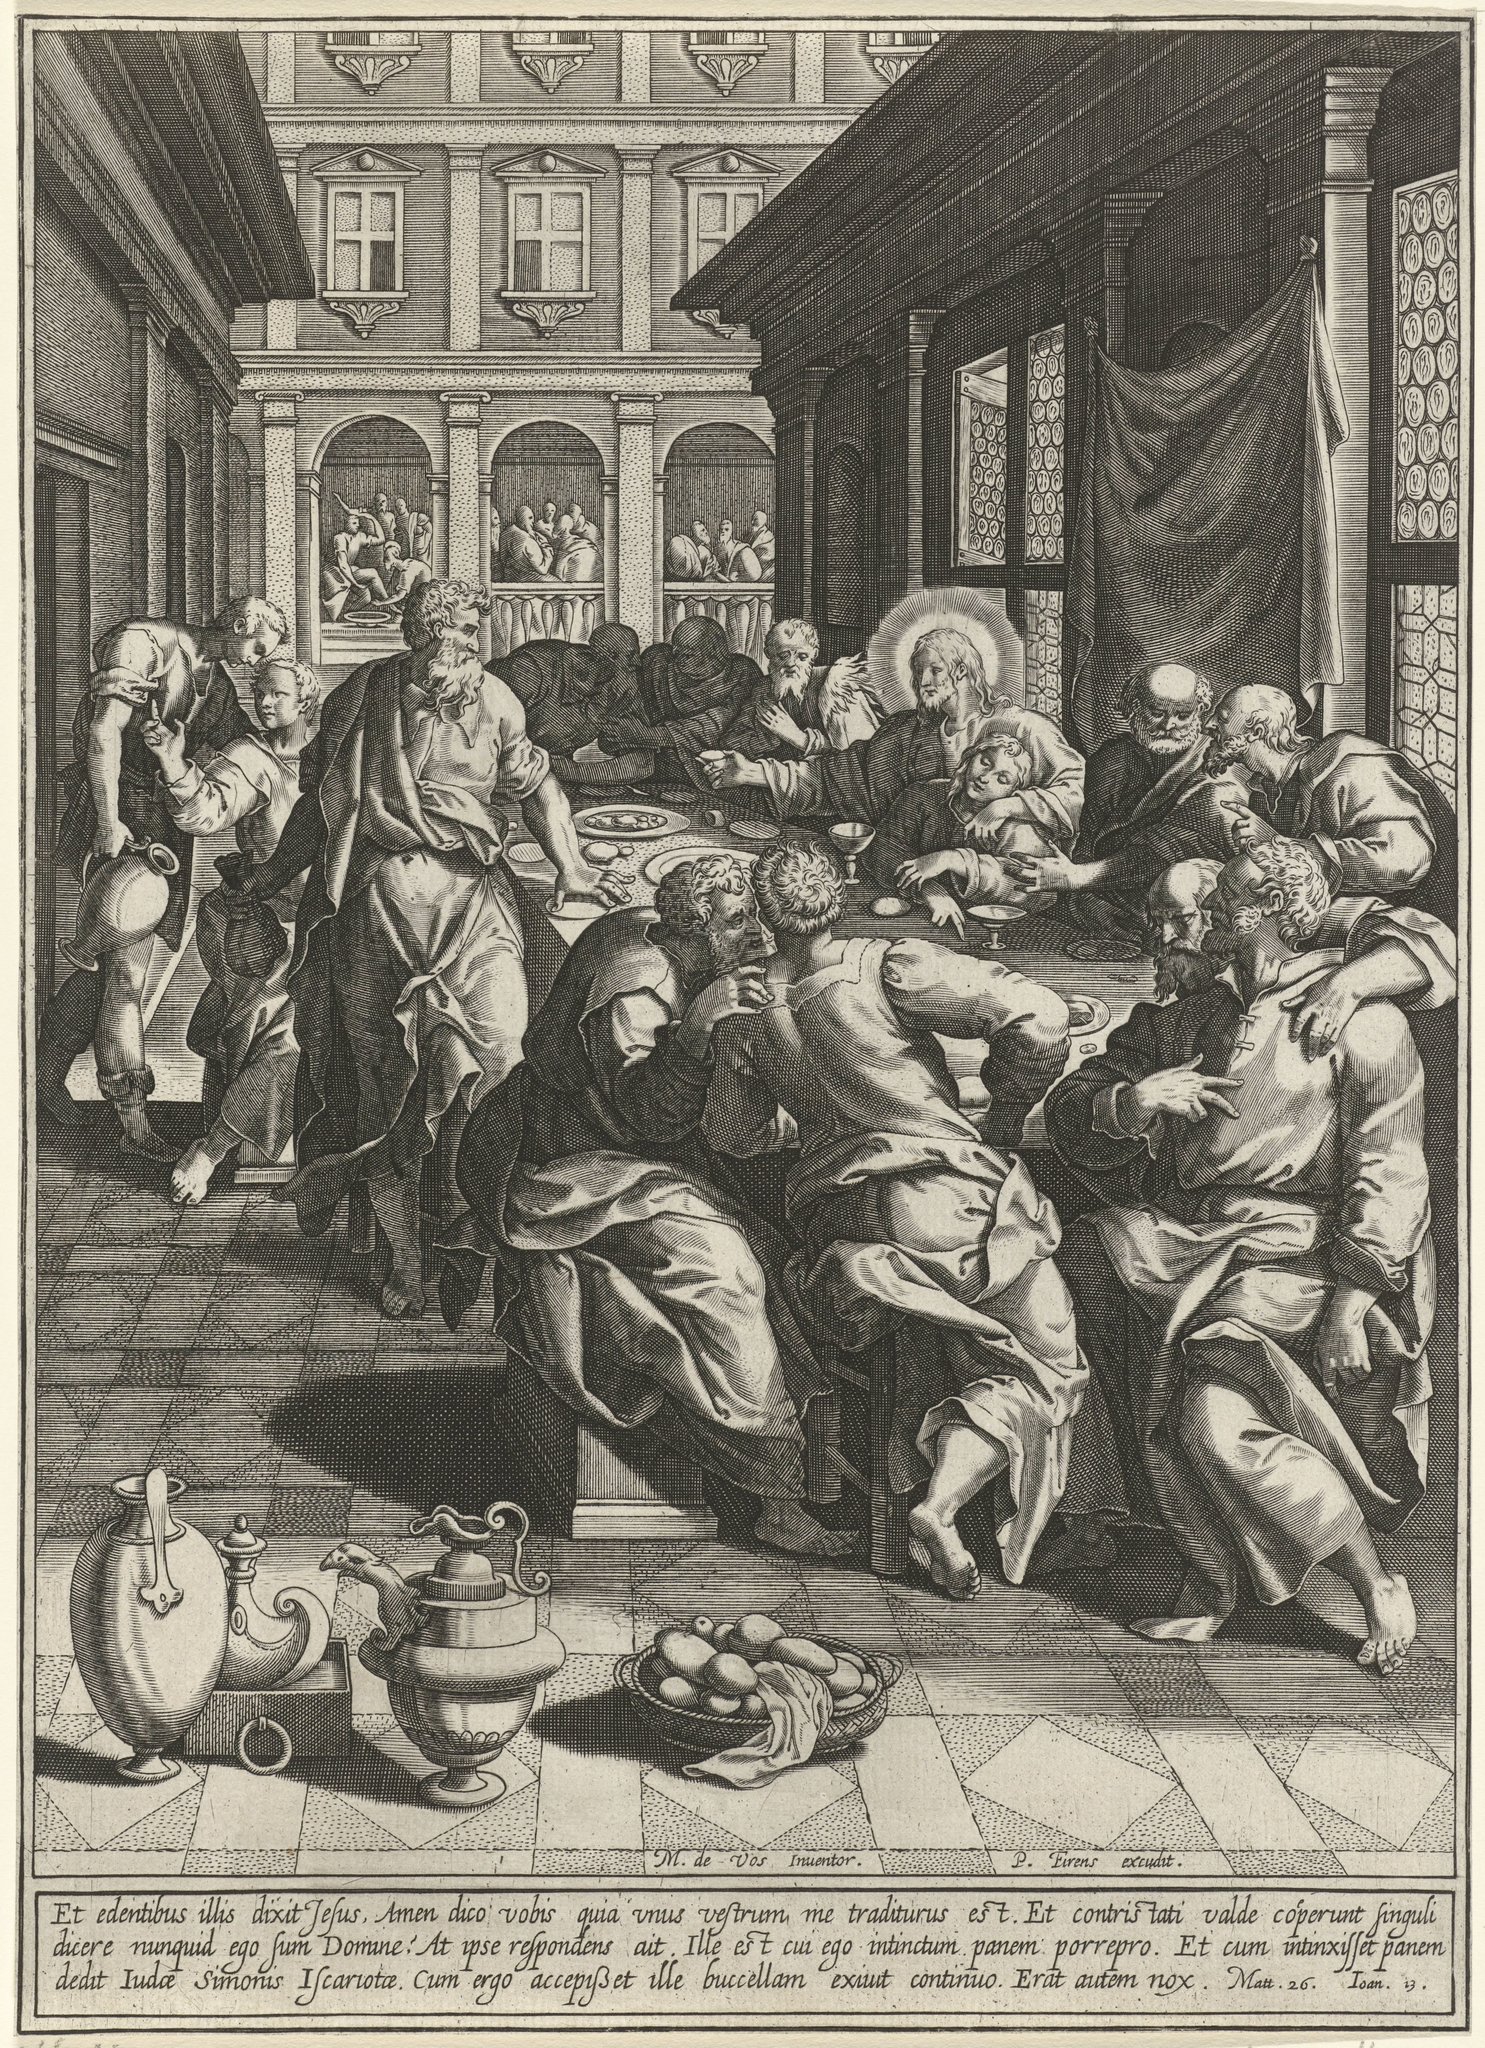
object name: print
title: Passie en wederopstanding van Christus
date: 1590-1638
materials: paper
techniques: engraving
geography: antwerp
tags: last supper (in general) (matthew 26:21-35; mark 14:18-31; luke 22:3, 22:15-23; john 13:21-38)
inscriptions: collector's mark: Lugt 2228, collector's mark: Lugt 2760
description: Christus en zijn apostelen zitten samen aan een gedekte tafel. Christus toont zijn leerlingen een stuk brood. Judas staat rechtop. In zijn rechterhand een geldbuidel. De prent heeft een Latijns onderschrift met een tekst uit de Bijbel en is de eerste prent van een veertiendelige serie over de passie van Christus.